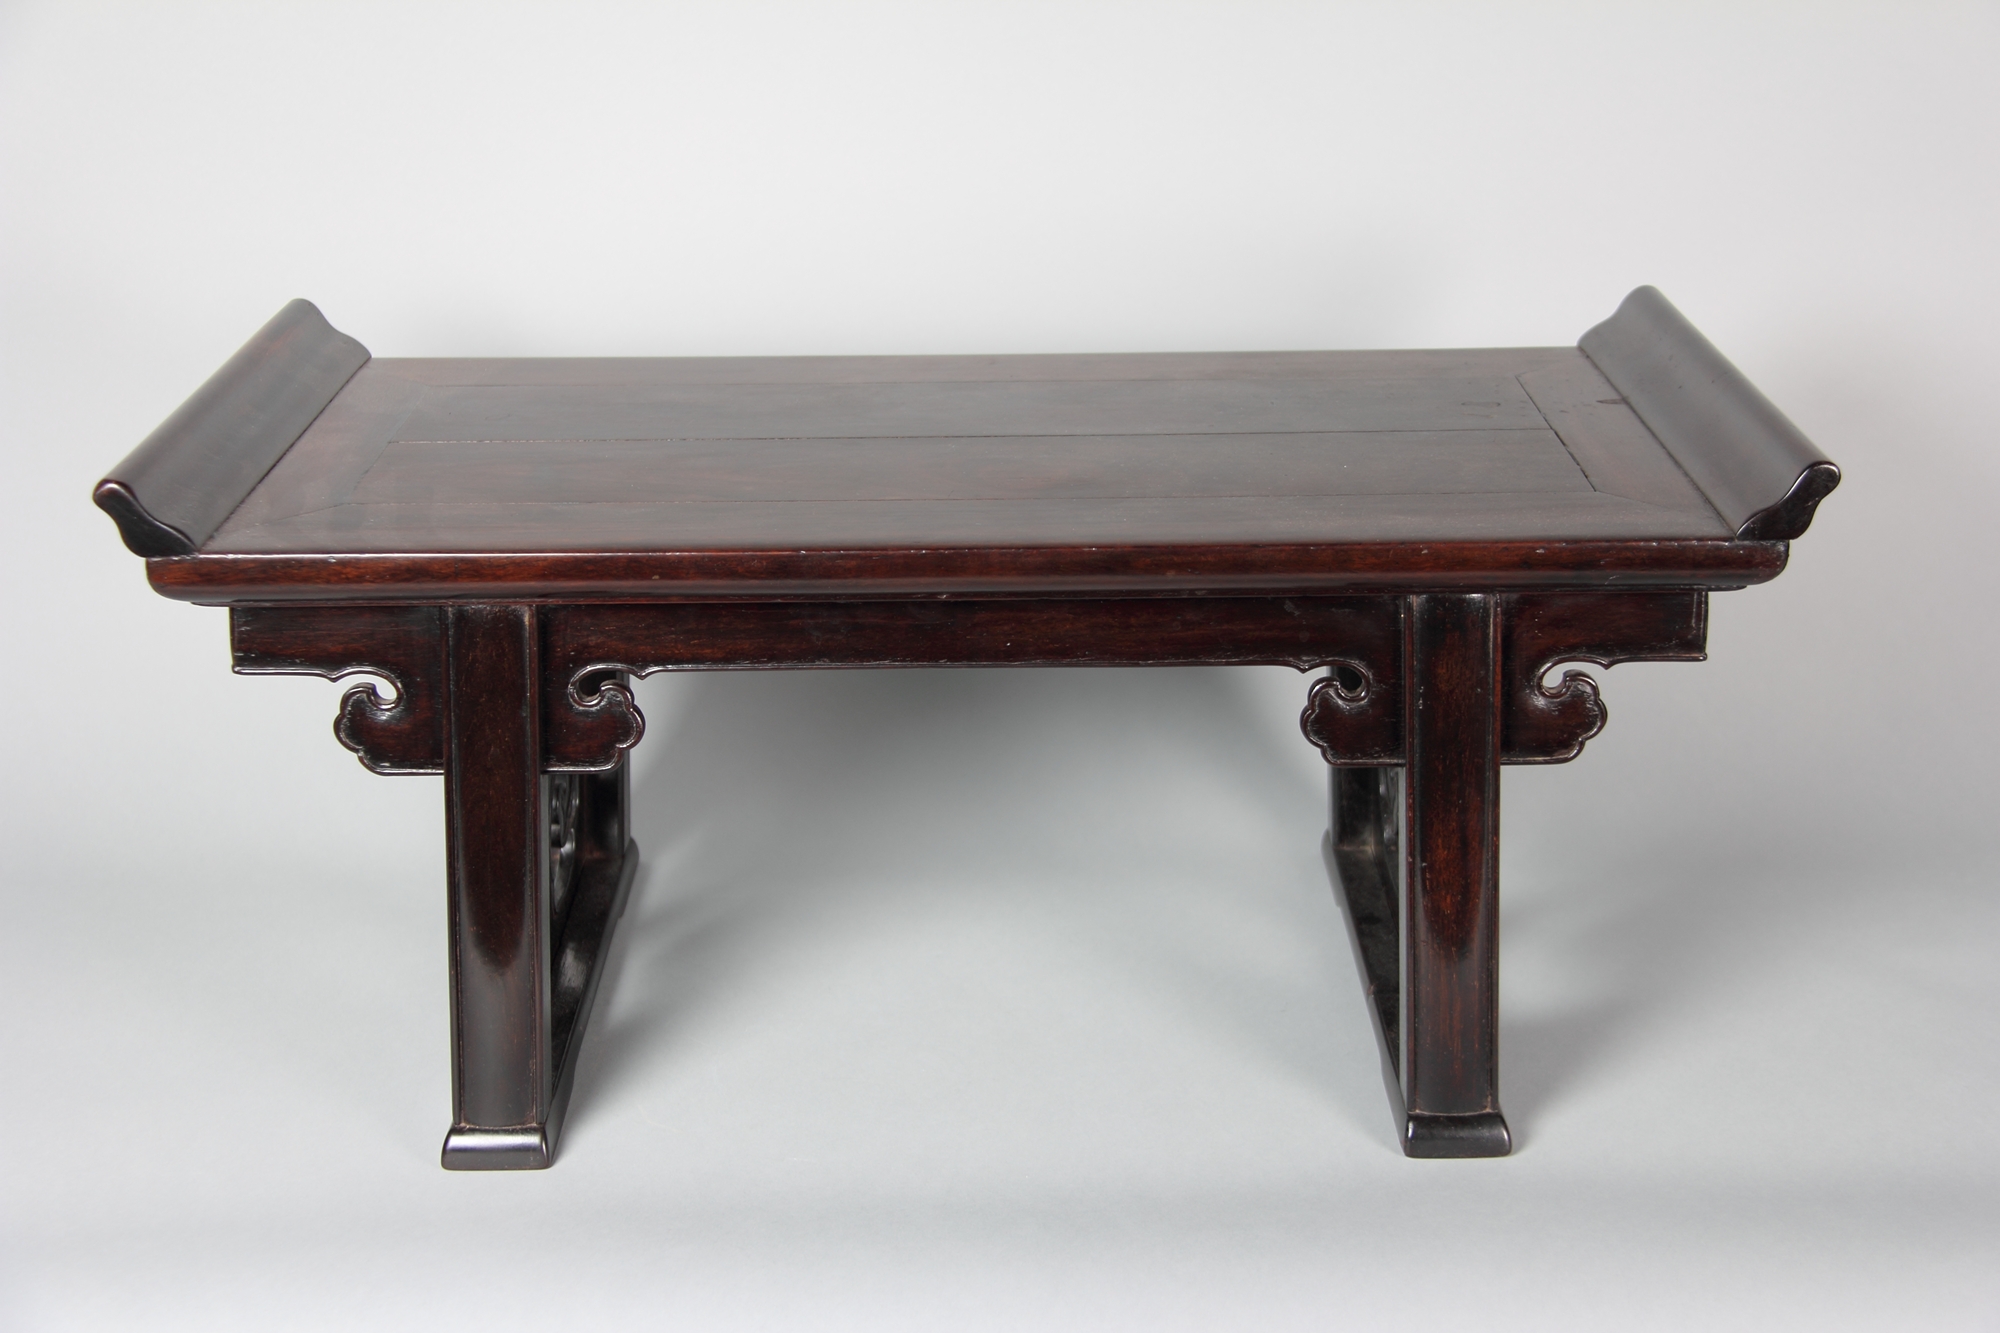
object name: table stand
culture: chinese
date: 1601-1700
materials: wood